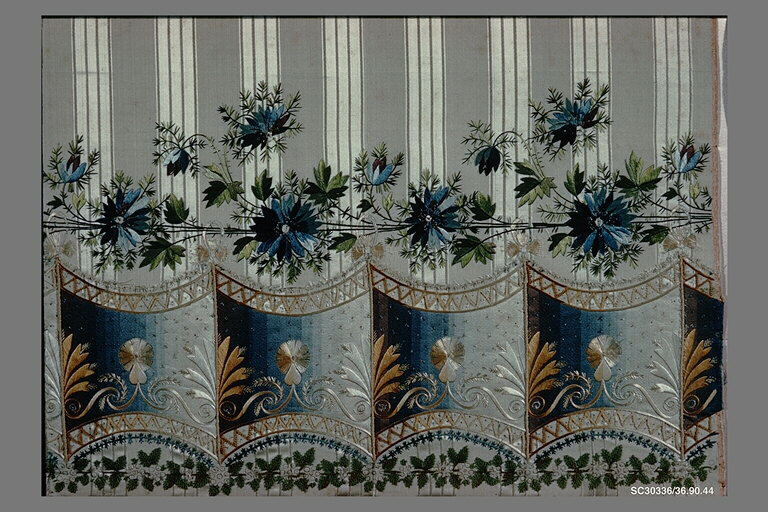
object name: border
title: Dress border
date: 1801-1833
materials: silk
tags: flowers